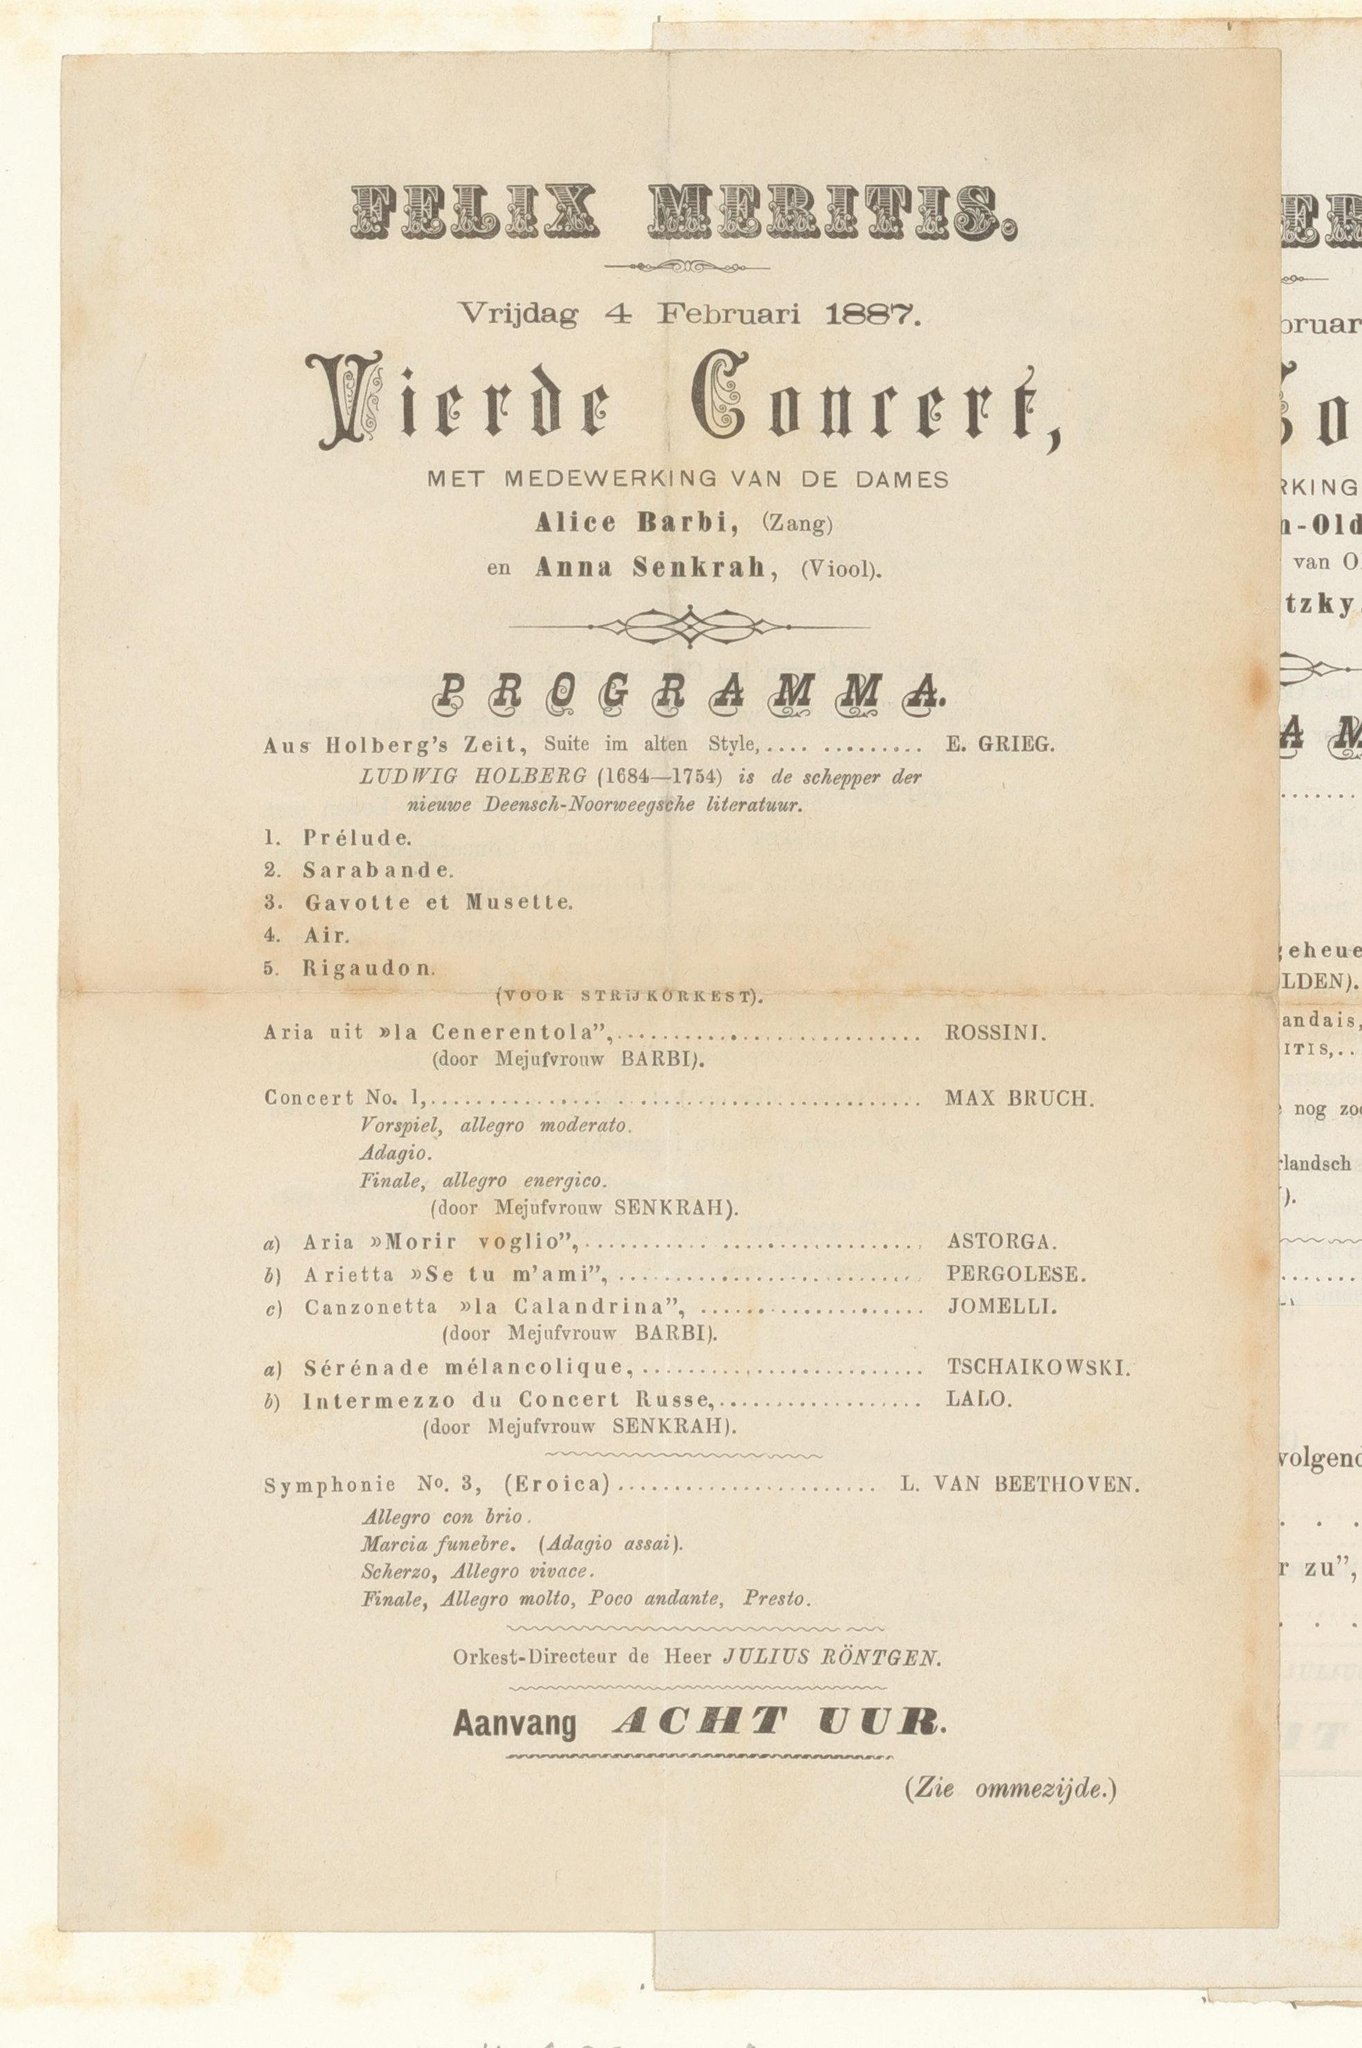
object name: programma, programmaboekje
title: Programma voor een concert in Felix Meritis op 4 februari 1887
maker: Anonymous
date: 1887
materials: paper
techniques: letterpress printing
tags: utrecht, julius röntgen, listening to music, large group of musicians, orchestra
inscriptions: collector's mark, collector's mark: Lugt 1641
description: Gedrukt programma voor het Vierde Concert door het orkest onder leiding van Julius Röntgen, in Felix Meritis te Amsterdam op 4 februari 1887. Onderwerpsrubrieken binnen de Atlas Zeden en Gewoonten: Muziek en muziekinstrumenten: Varia.